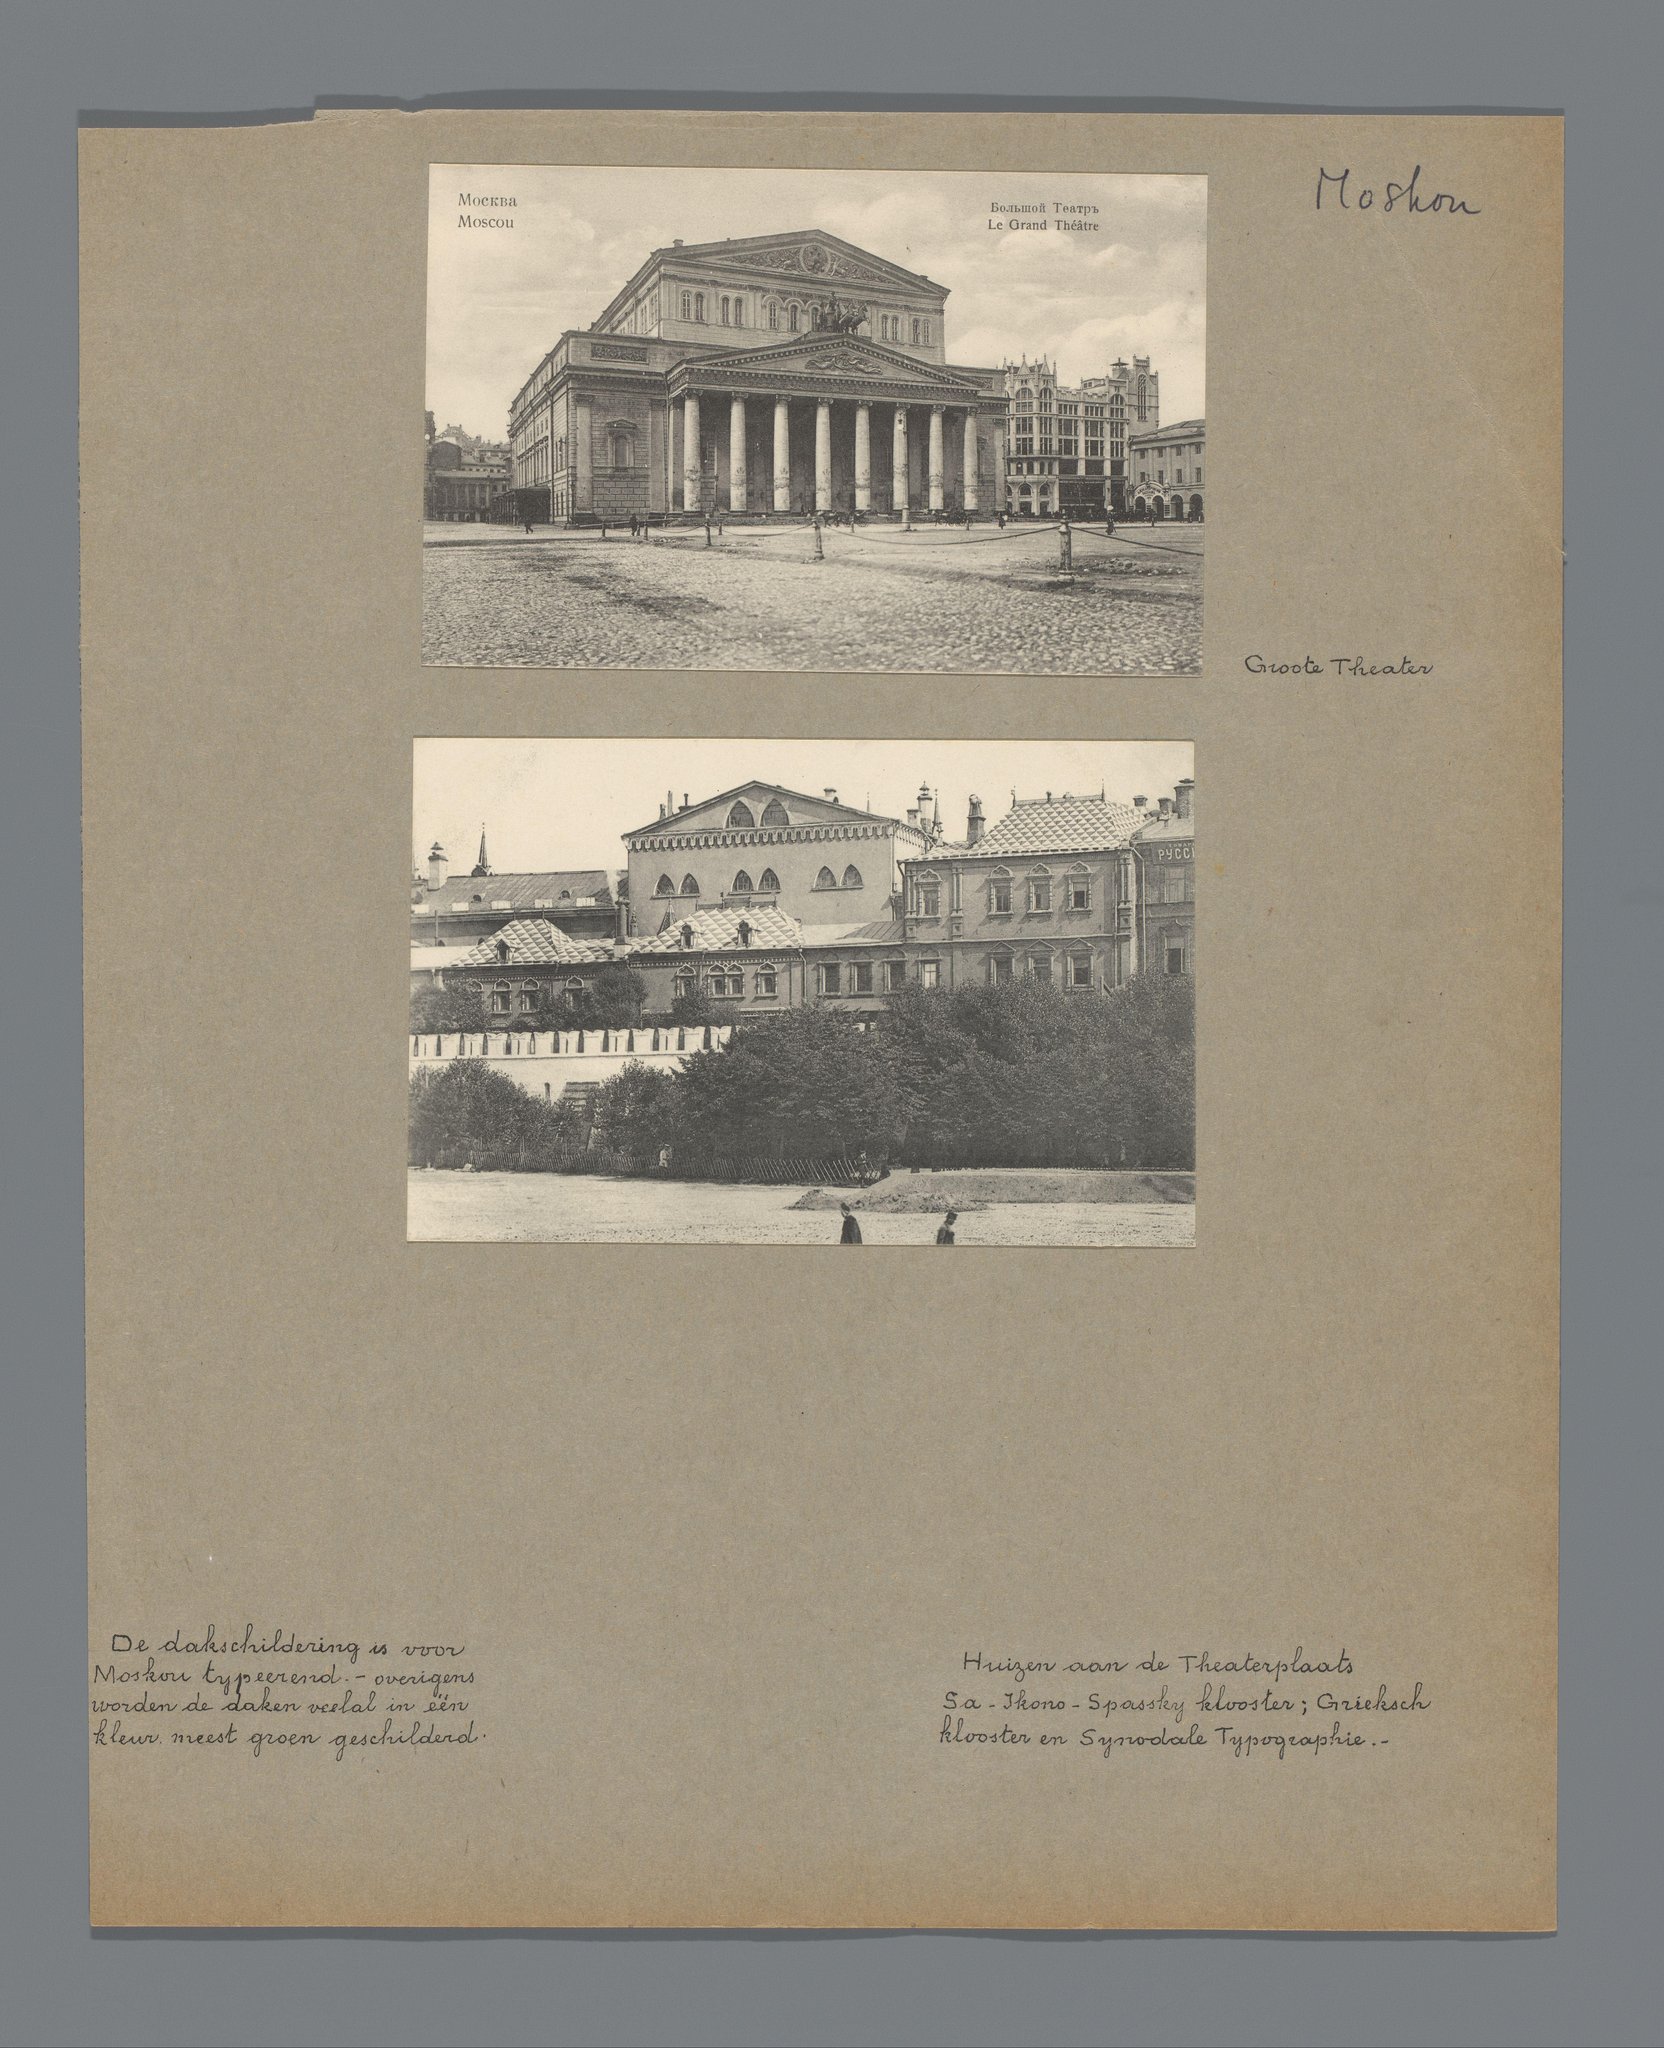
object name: photograph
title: Moskou. Groote Theater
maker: Anonymous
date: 1860-1925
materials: photographic support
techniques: photograph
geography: russia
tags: moskou